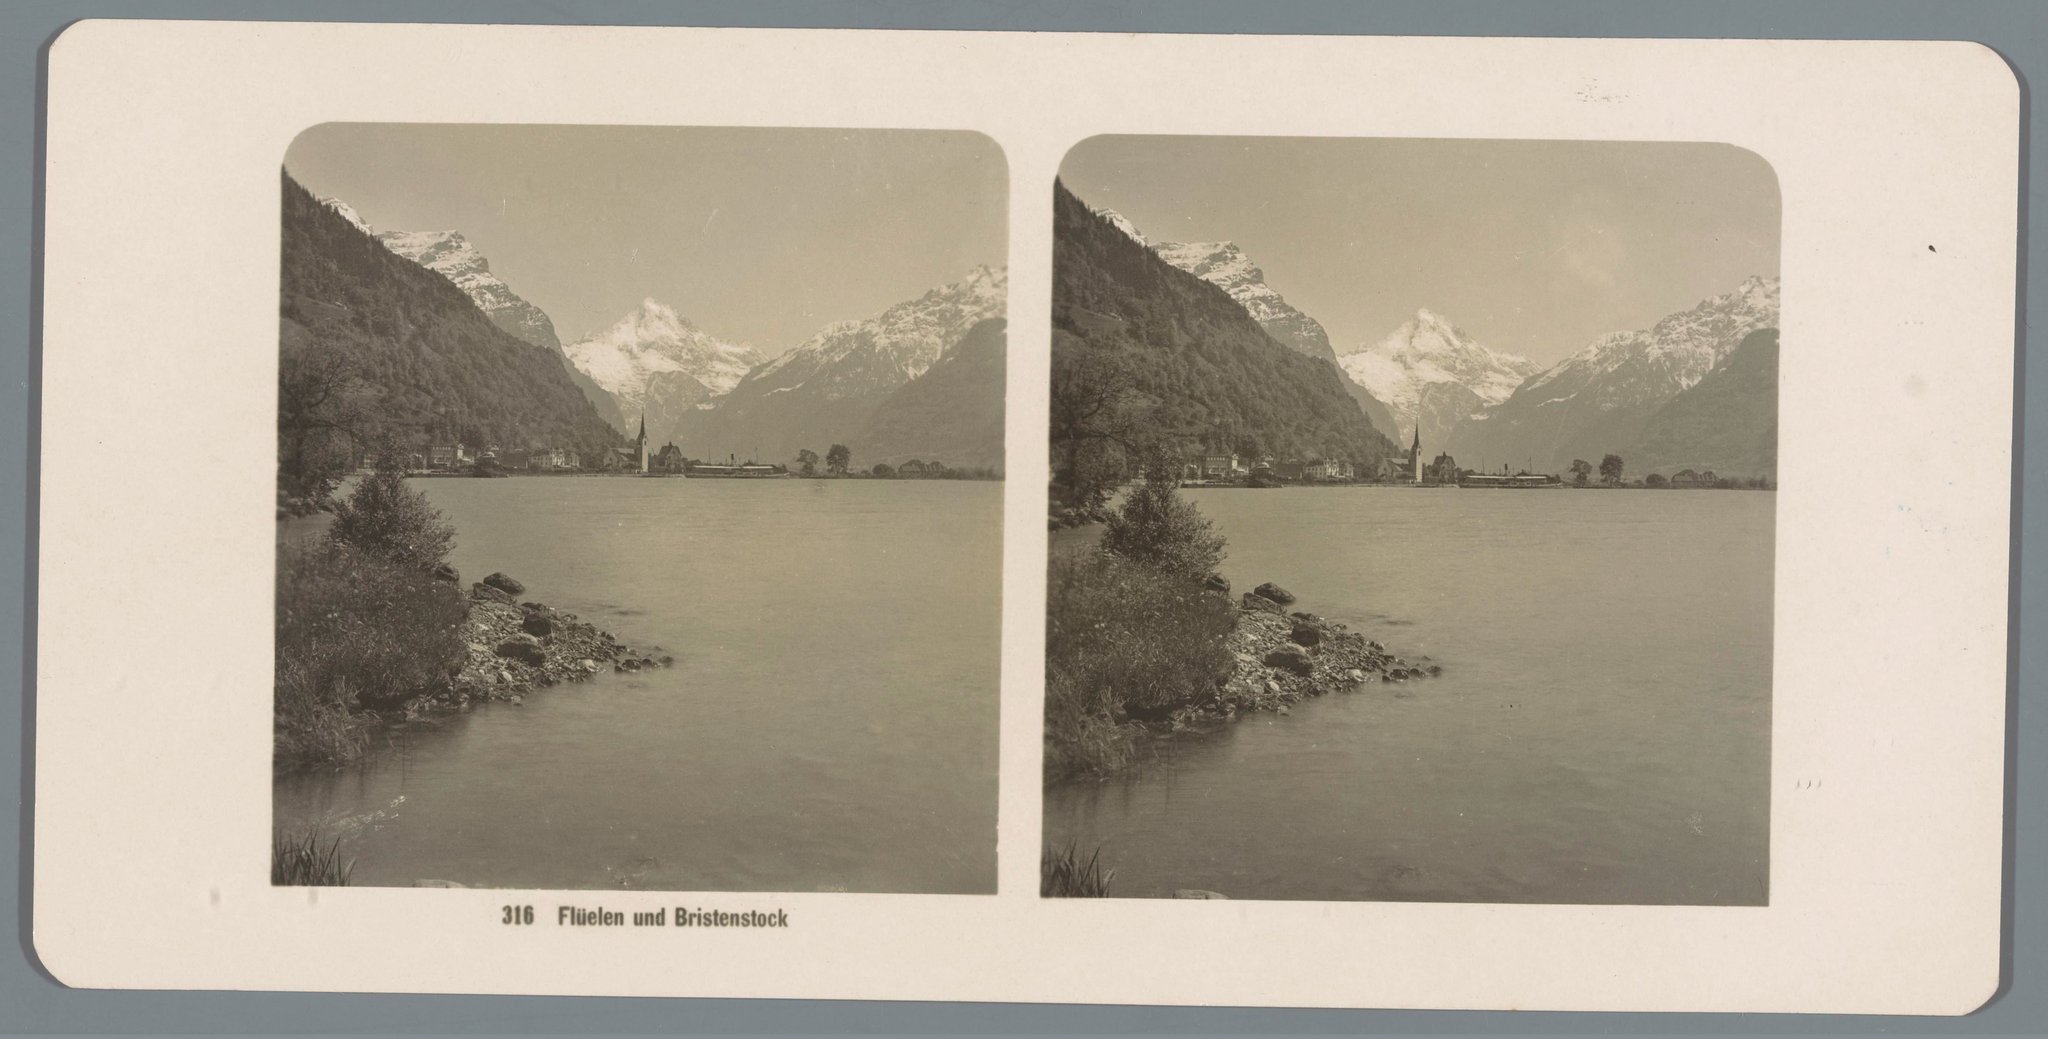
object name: stereograph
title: Gezicht op Flüelen en de Bristenstock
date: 1900-1910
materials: cardboard, photographic support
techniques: gelatin silver print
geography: uri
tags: city-view in general; 'veduta', mountain-top, peak, lake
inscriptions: inscription: ‘Wehrli A.-G. Kilchberg-Zürich’, number: ‘316’